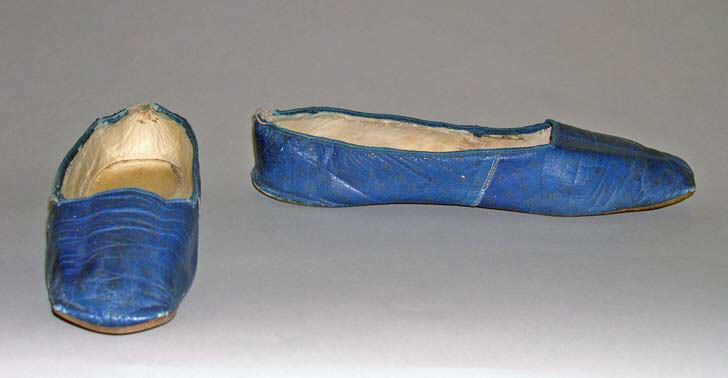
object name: slipper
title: Slippers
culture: french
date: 1820-1840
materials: leather